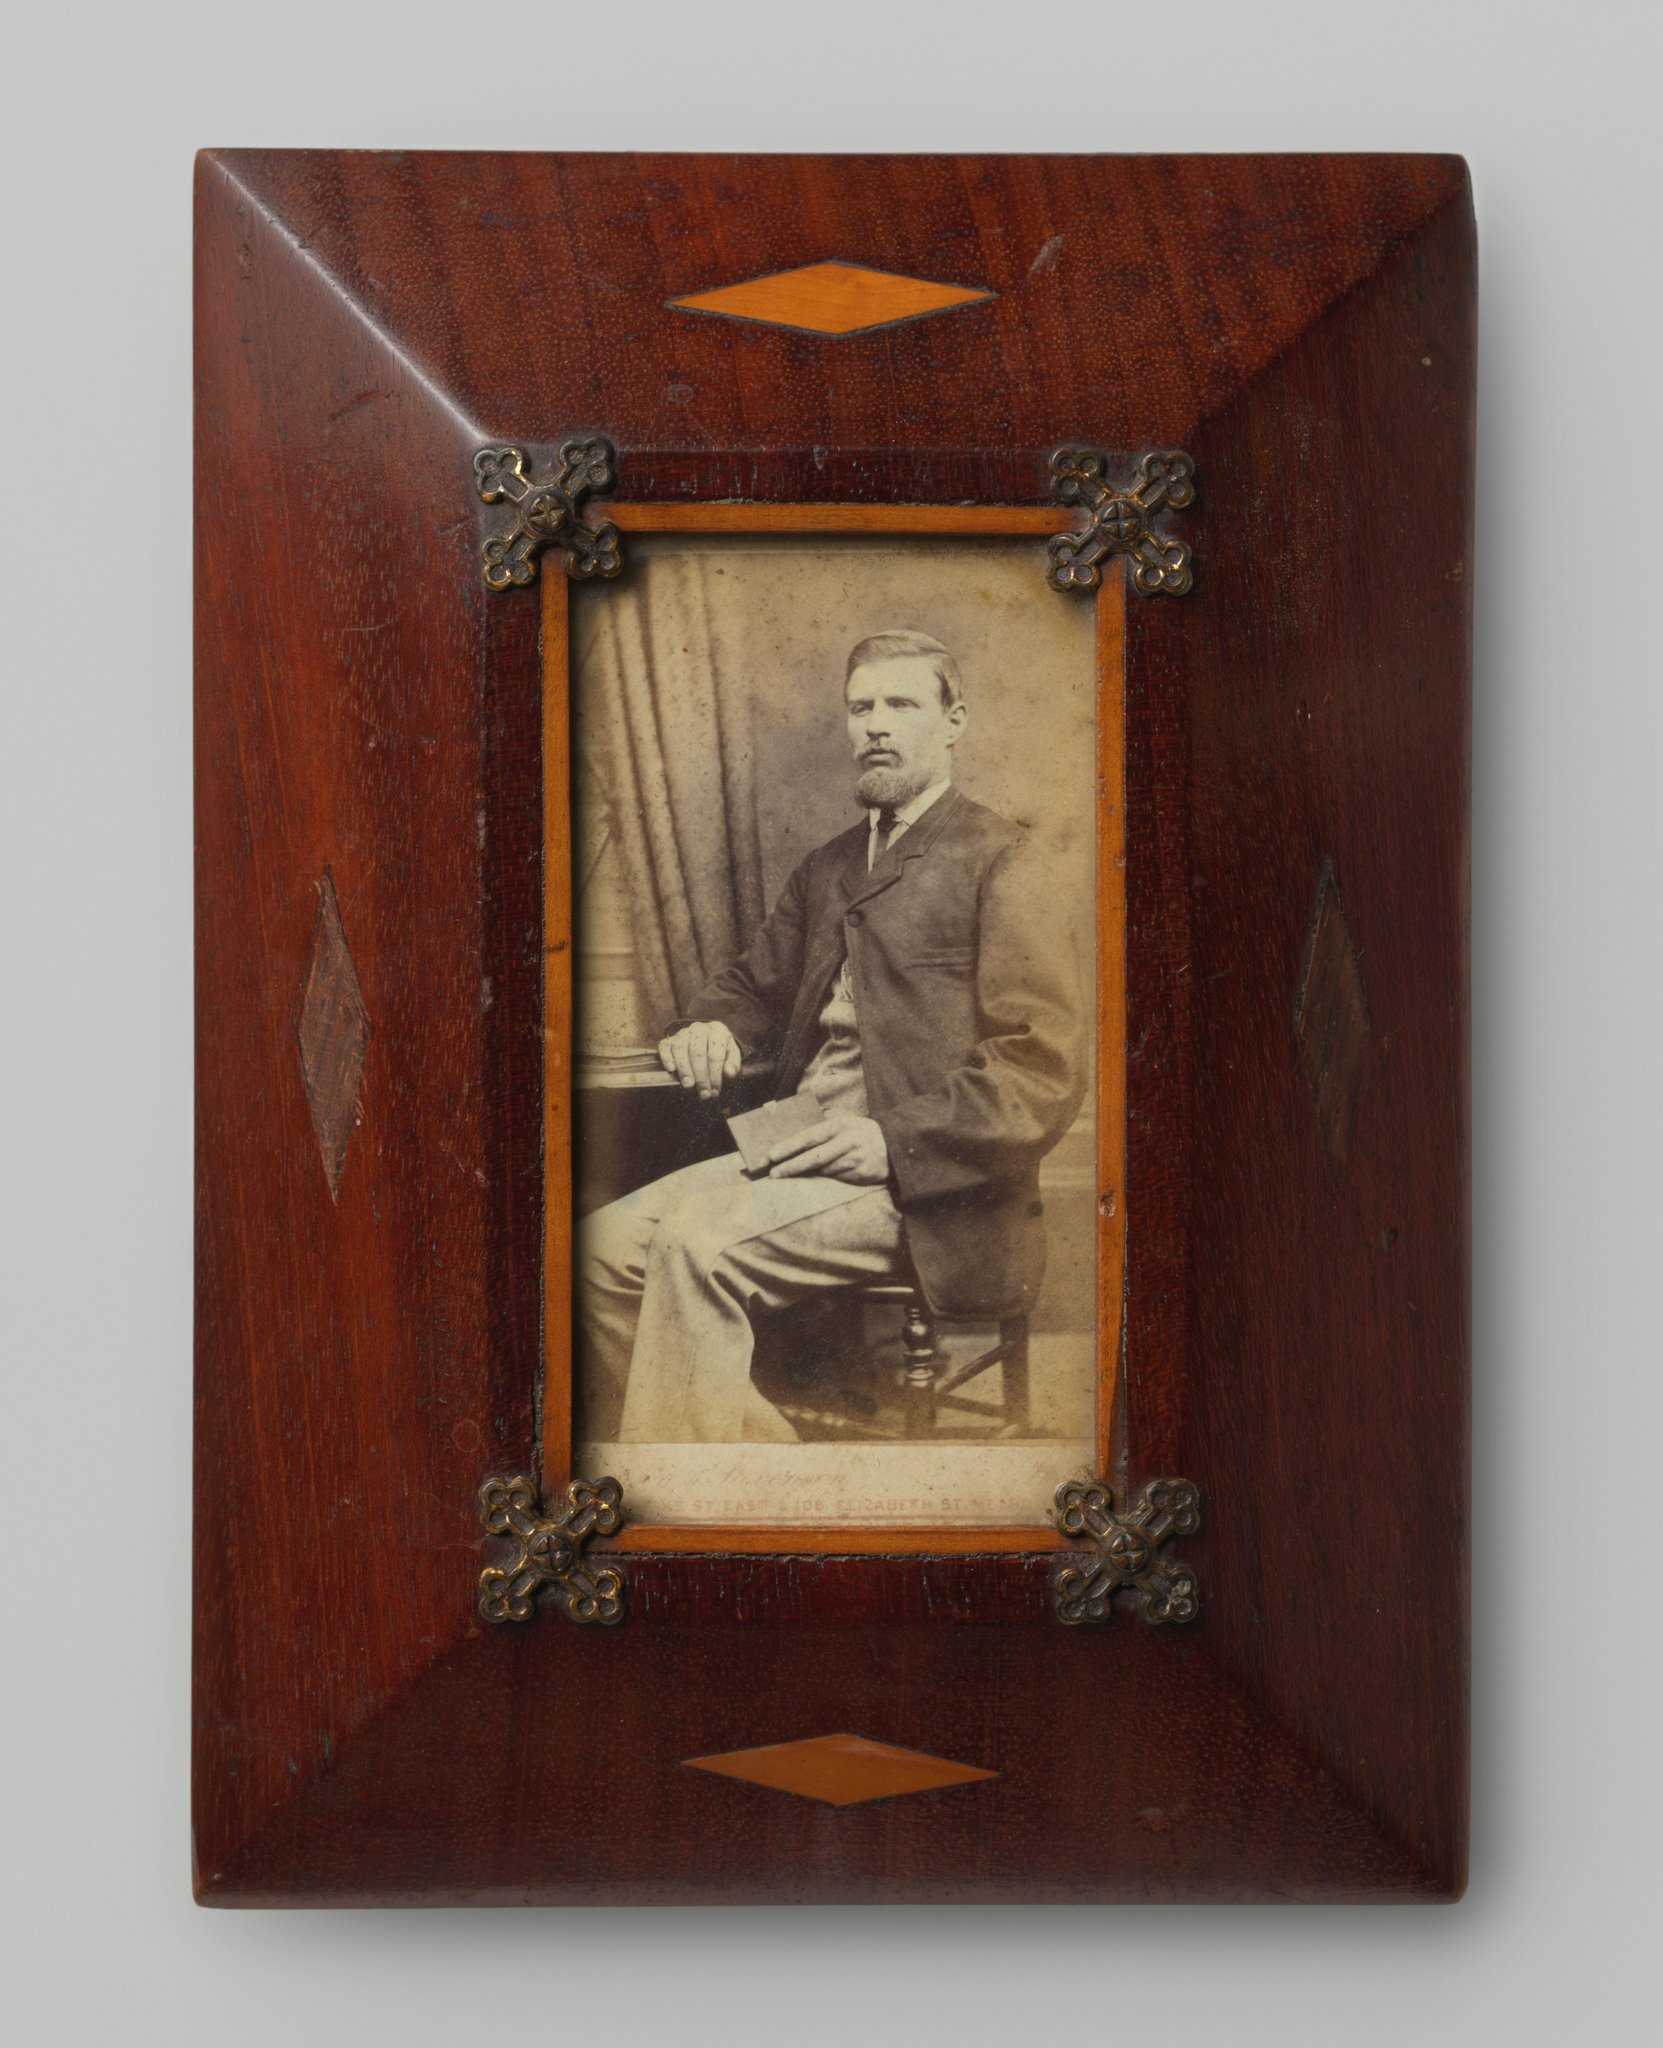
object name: photograph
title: Portret van een onbekende zittende man met een boek in zijn handen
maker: Anonymous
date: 1880-1900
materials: cardboard, glass, metal, paper, wood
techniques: albumen print, inlay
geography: melbourne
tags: sitting figure, book, anonymous historical person portrayed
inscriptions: : ‘[...] st. East & 10b Elisabethst. Melbourne/ [...] can be obtained at any [...]’